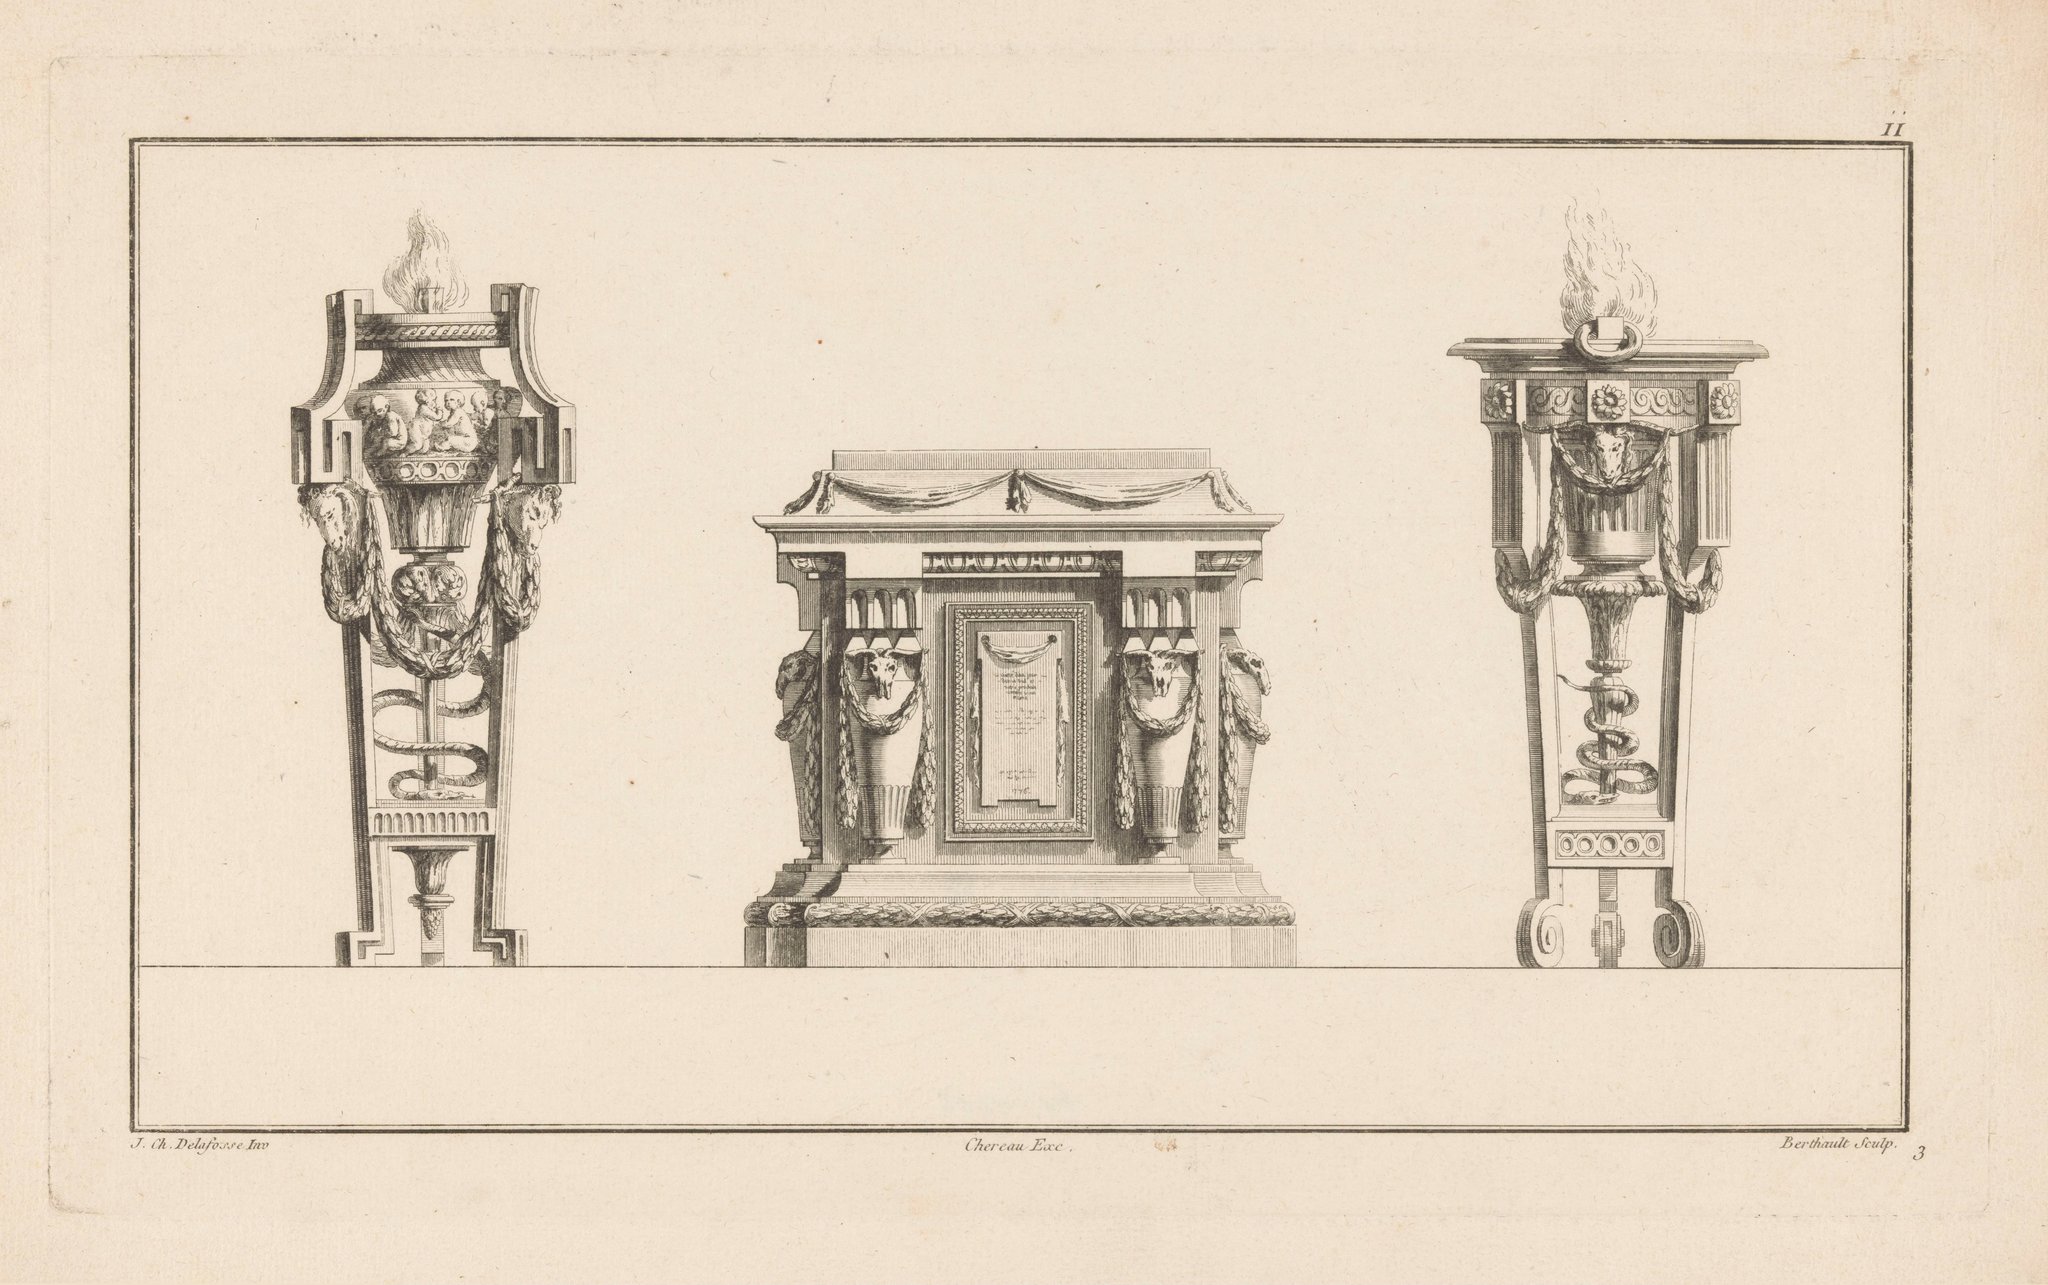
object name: print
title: IIe Volume De l'Oeuvre de J. Ch. Delafosse (...)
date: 1771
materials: paper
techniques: engraving, etching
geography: paris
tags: tripod, pedestal of a piece of sculpture (perhaps in the form of a herm)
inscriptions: collector's mark: Lugt 2760, collector's mark: Lugt 2228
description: Twee geornamenteerde Athéniennes (driepoten) met vuur aan weerszijden van een voetstuk met vazen en bucraniums.